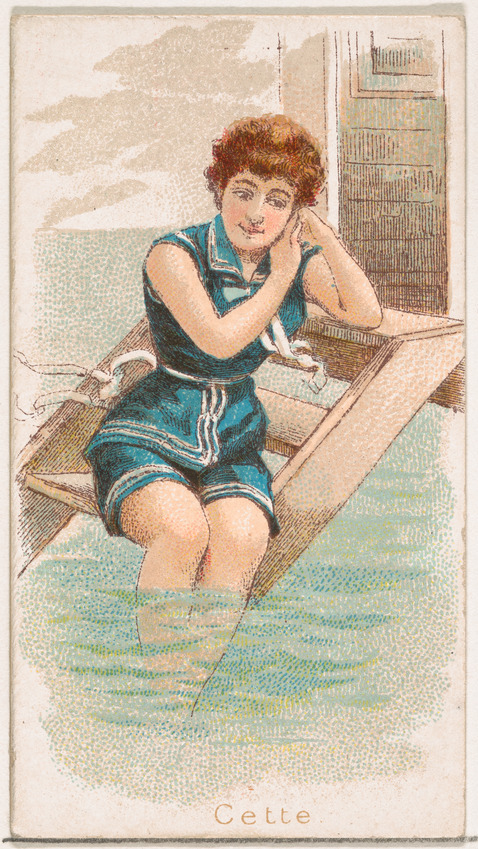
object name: print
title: Cette, from the Fancy Bathers series (N187) issued by Wm. S. Kimball & Co.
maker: william s. kimball & company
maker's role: publisher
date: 1889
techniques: color lithograph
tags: women